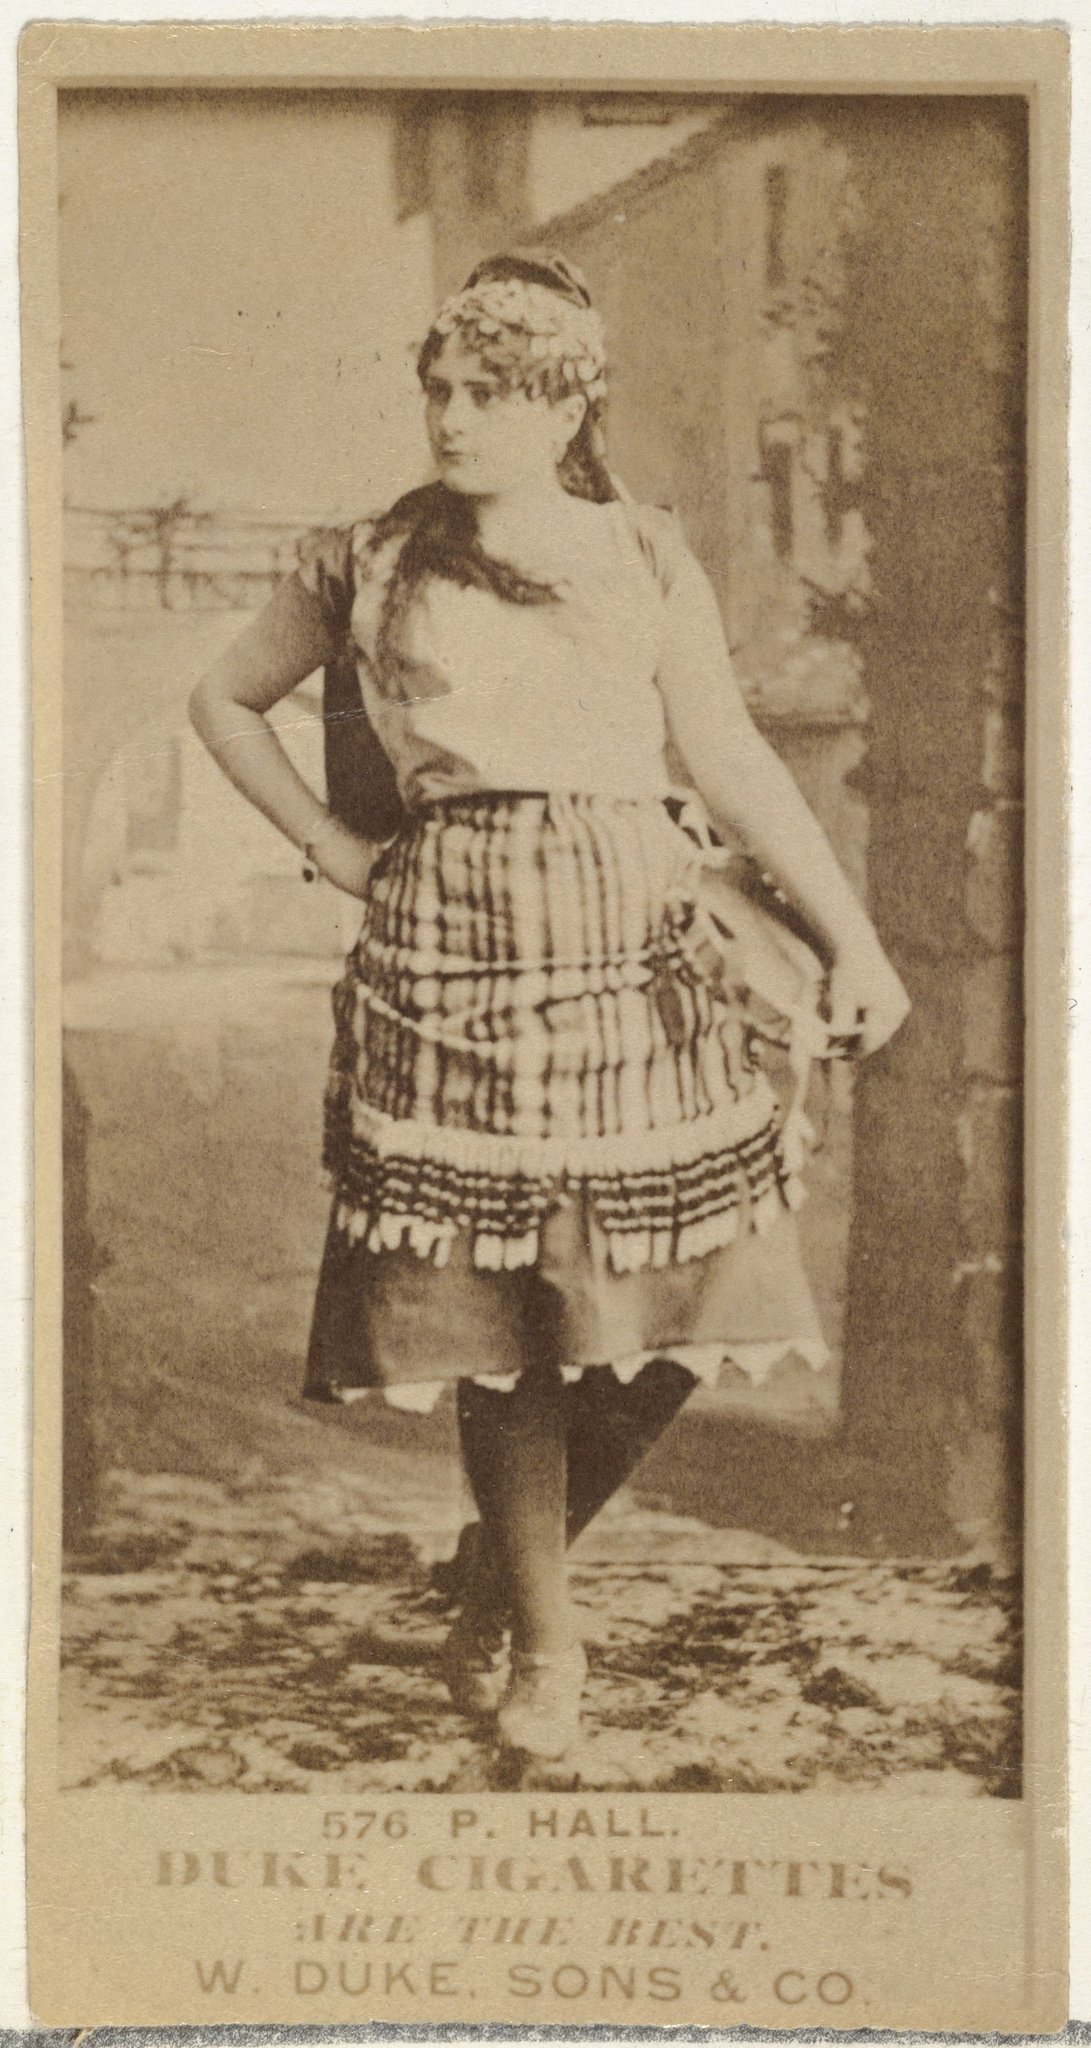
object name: photograph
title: Card Number 576, P. Hall, from the Actors and Actresses series (N145-7) issued by Duke Sons & Co. to promote Duke Cigarettes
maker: w. duke, sons & co.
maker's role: publisher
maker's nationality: american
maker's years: 1870-1920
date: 1880-1889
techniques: albumen silver print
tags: portraits,women,actresses